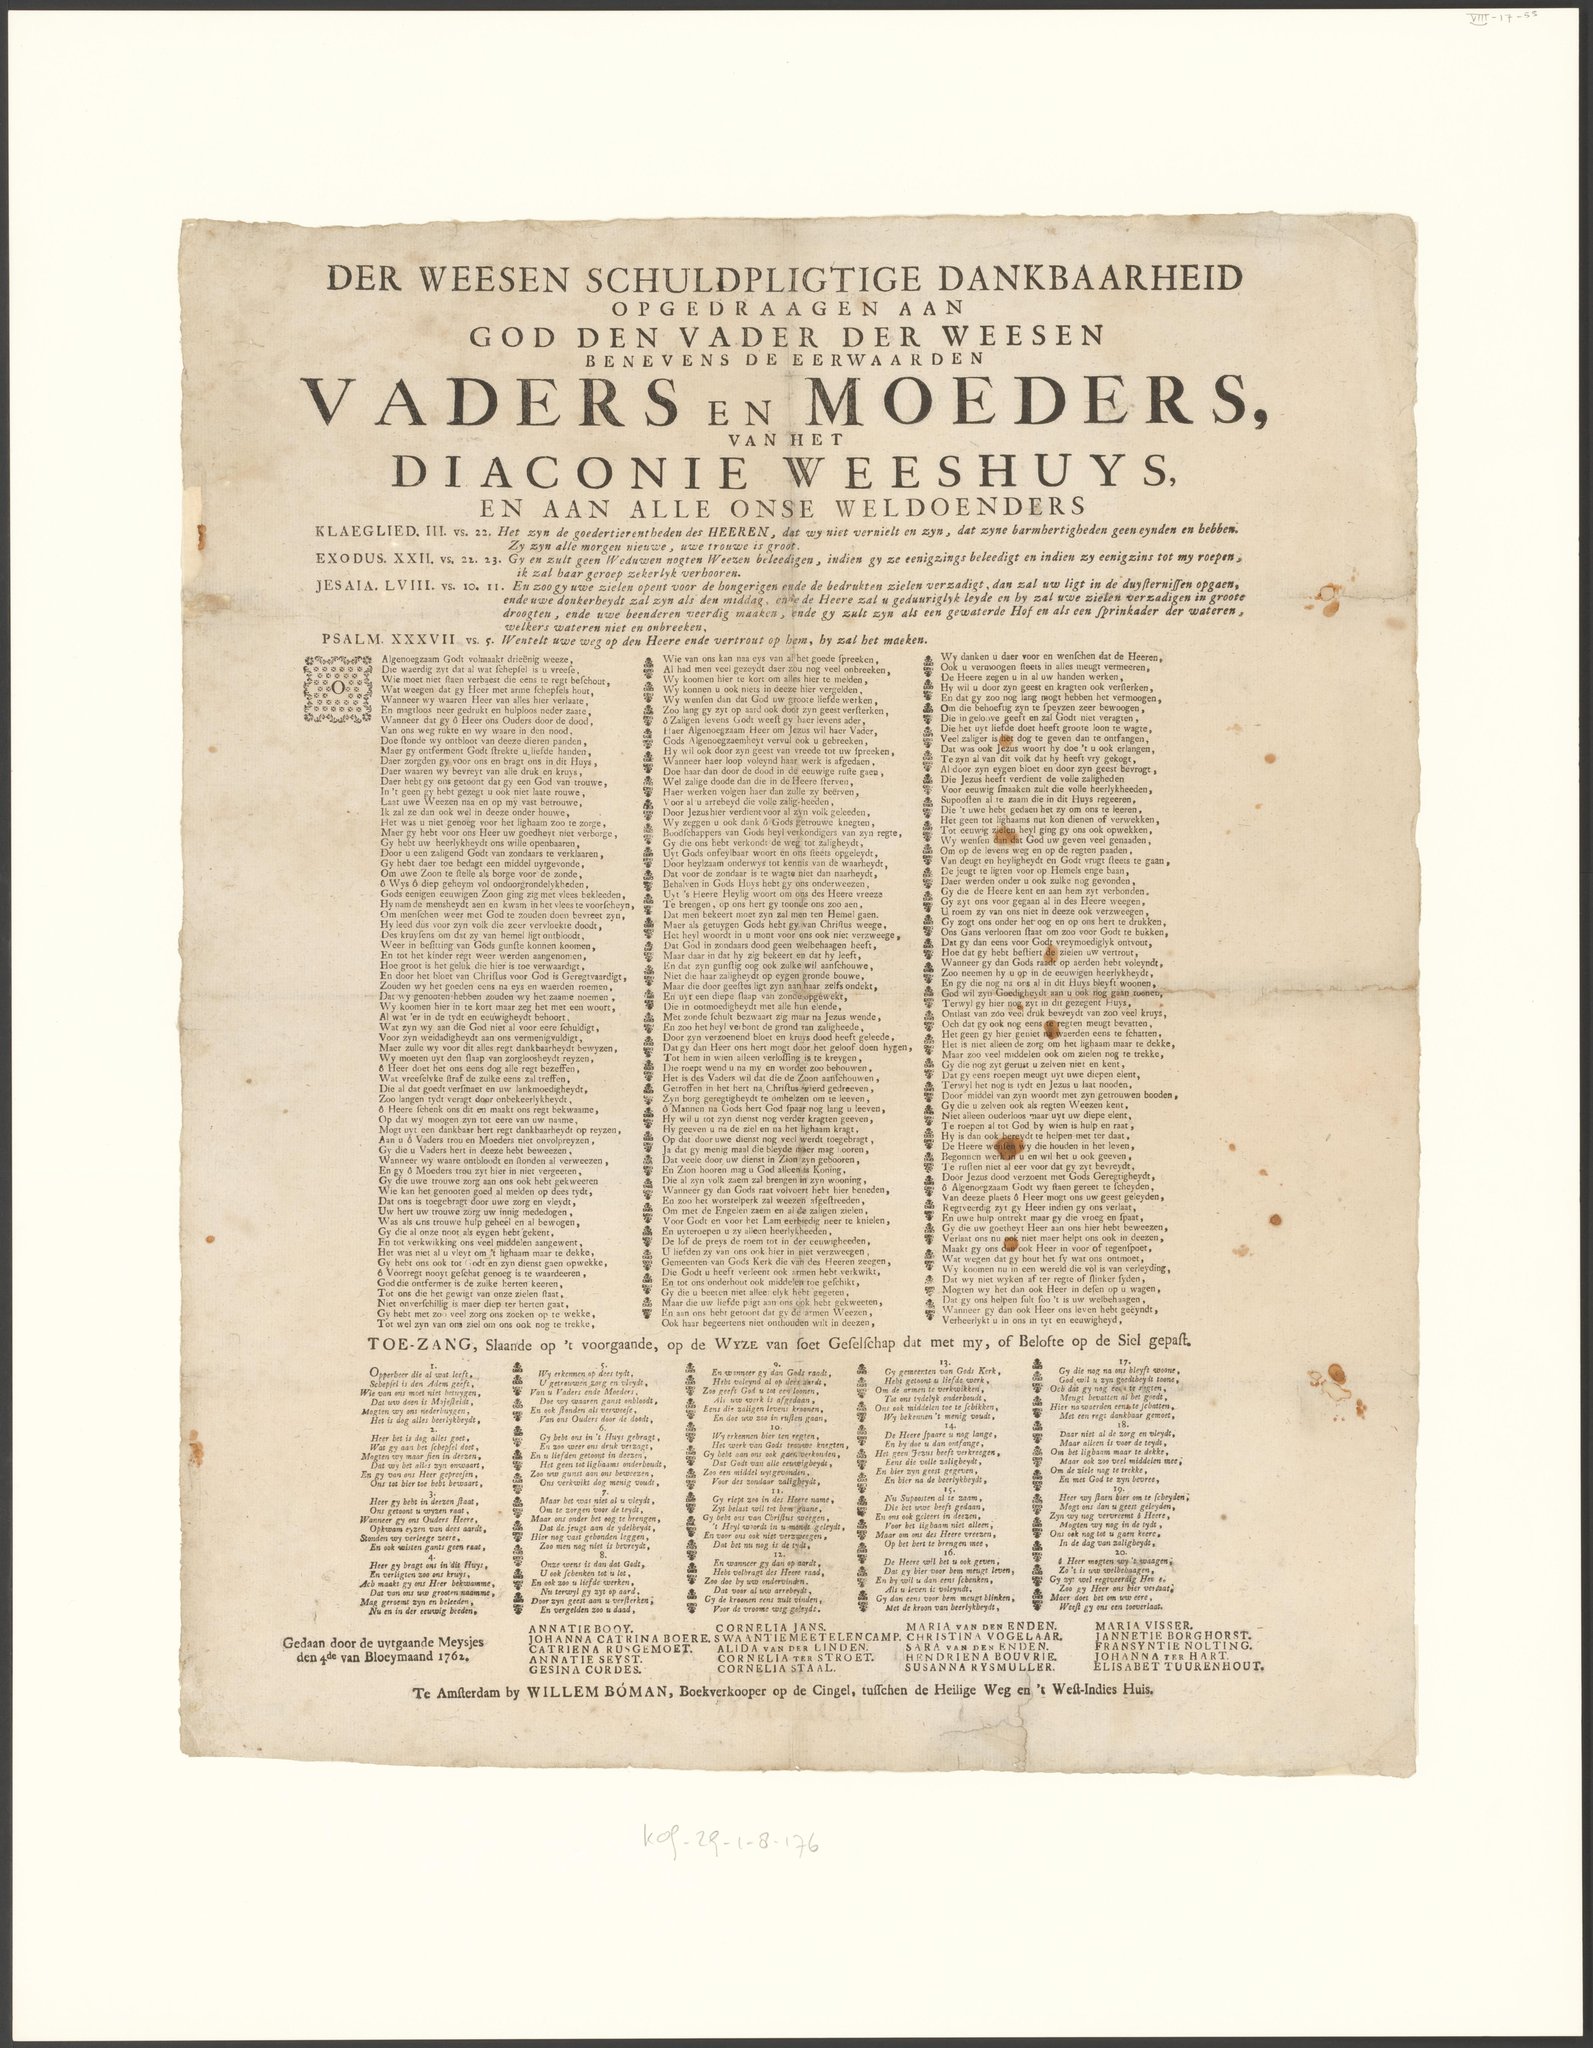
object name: text sheet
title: Der weesen schuldpligtige dankbaarheid opgedraagen aan God den Vader der weesen benevens de eerwaarden Vaders en Moeders, van het Diaconie Weeshuys, en aan alle onse weldoenders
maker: willem boman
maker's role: printer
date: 1762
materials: paper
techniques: letterpress printing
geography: amsterdam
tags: public welfare, orphans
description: Gedicht opgedragen aan de vaders en moeders van het Diaconie Weeshuis te Amsterdam, door de uitgaande weesmeisjes, 4 mei 1762. Gedicht in drie kolommen, onderaan een toezang en een lijst met de namen van uitgaande meisjes. Onderwerpsrubrieken binnen de Atlas Zeden en Gewoonten: Armwezen en Liefdadigheid.